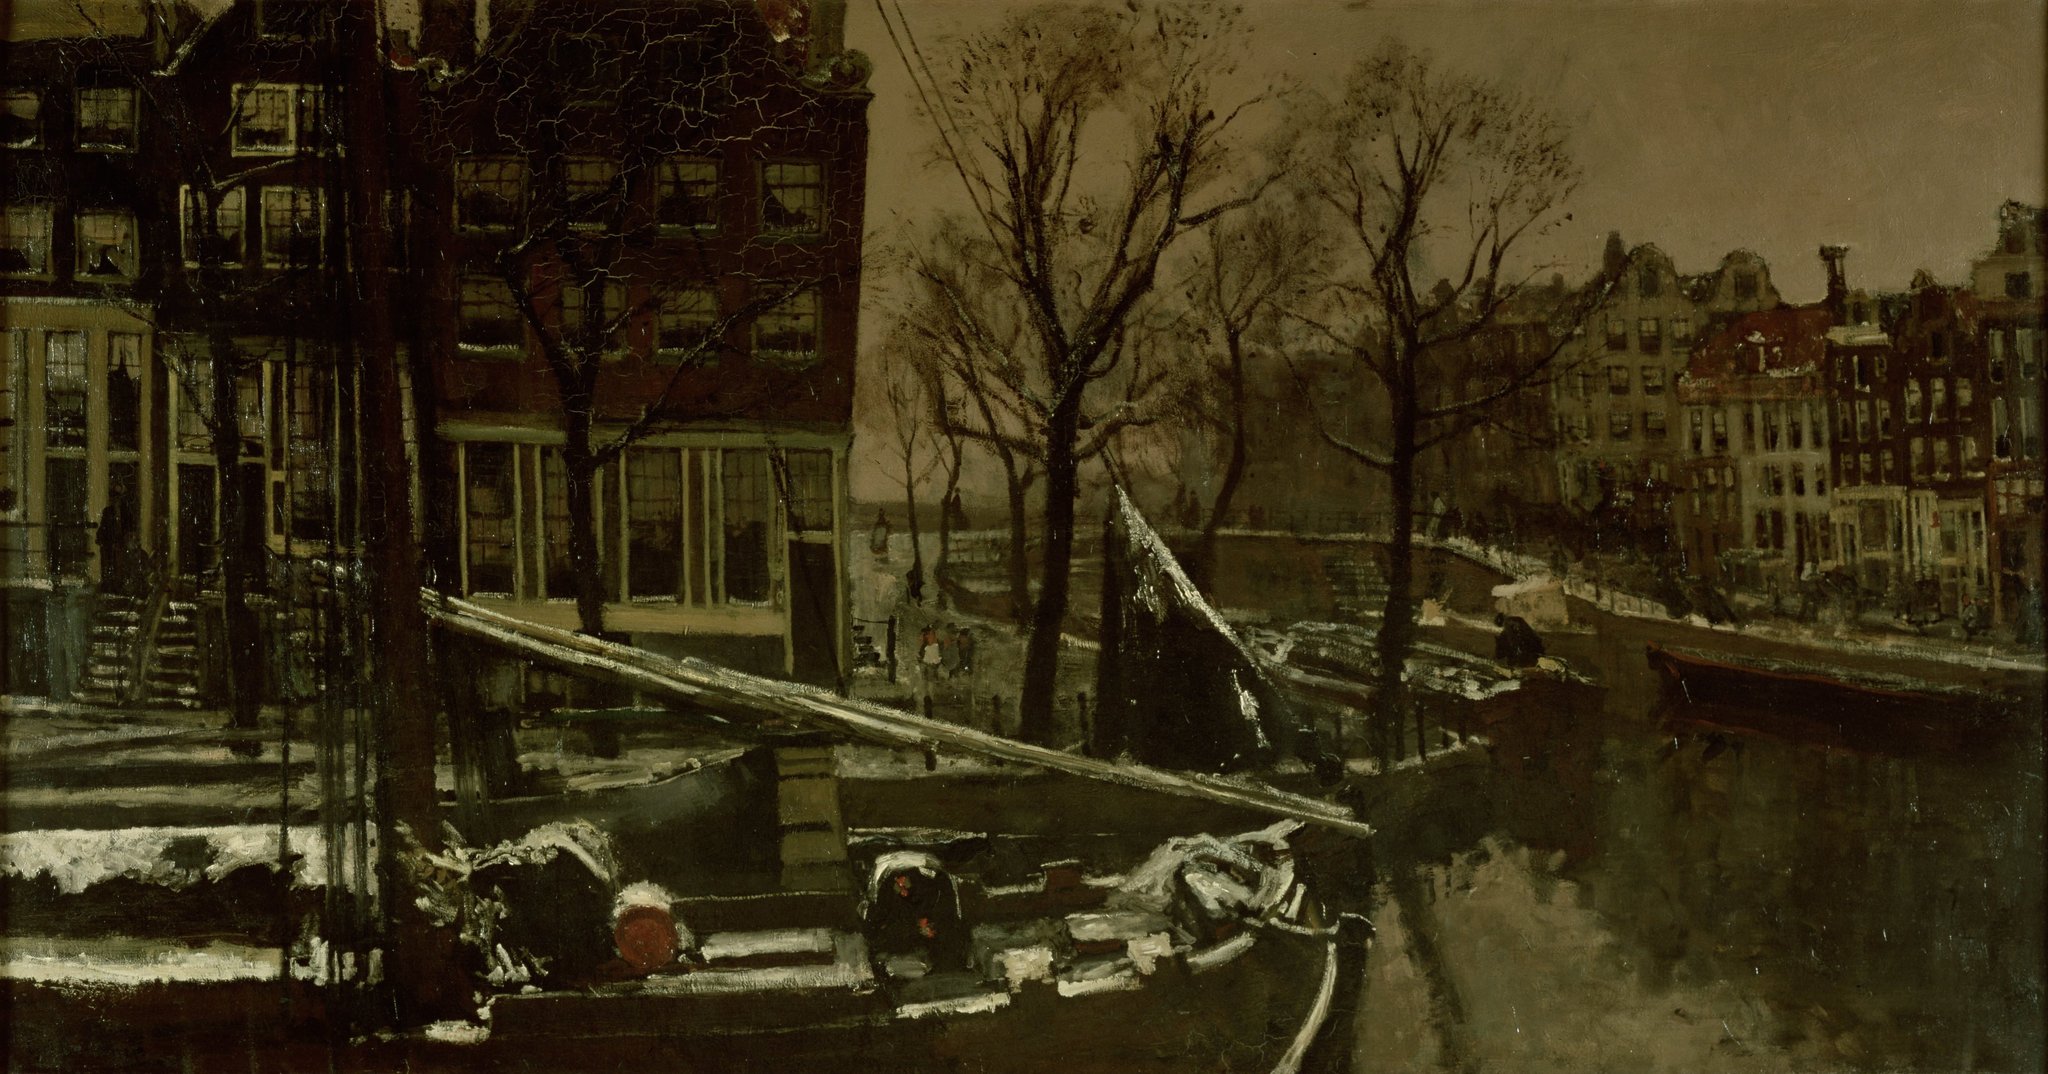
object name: painting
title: Winter in Amsterdam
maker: george hendrik breitner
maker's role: draughtsman, painter, print maker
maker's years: 1857-1923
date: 1900-1901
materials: canvas, oil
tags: canals, waters (in city), snow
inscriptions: signature: ‘G.H. Breitner’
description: Winter te Amsterdam. Gezicht op de hoek Brouwersgracht - Korte Prinsengracht. Op de voorgrond enige schuiten.